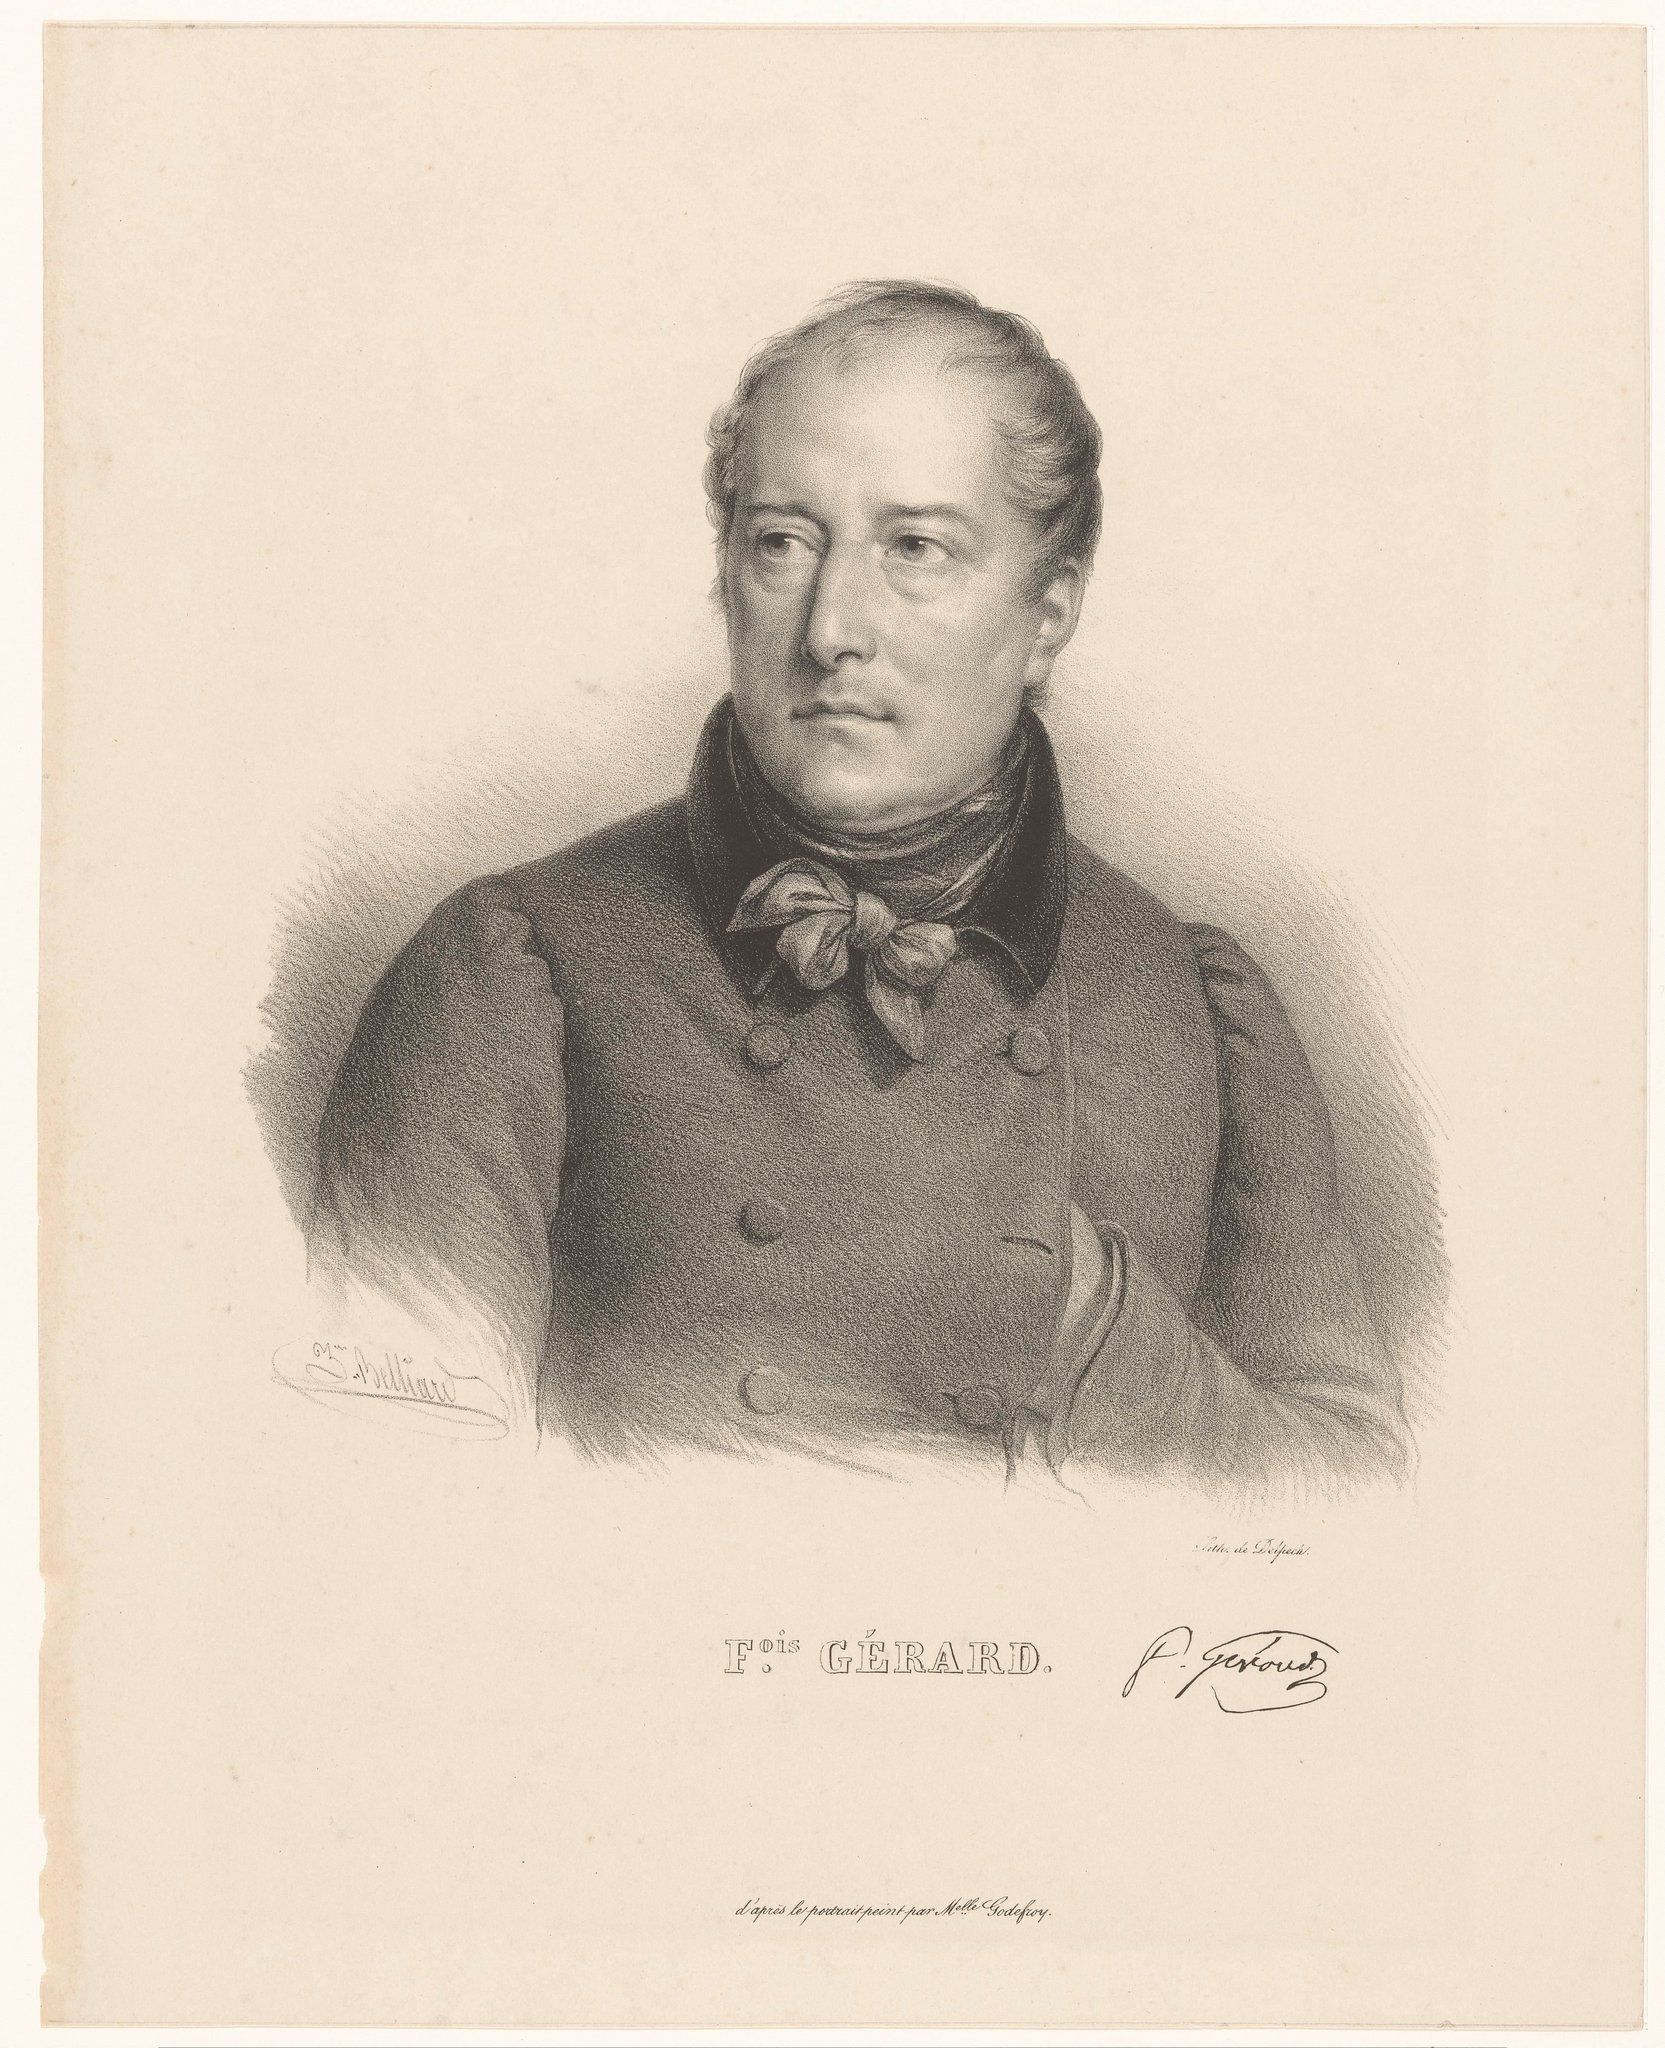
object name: print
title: F.ois Gérard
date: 1838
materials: paper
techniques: lithograph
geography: paris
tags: paris, françois gérard, historical persons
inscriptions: collector's mark: Lugt 2228a